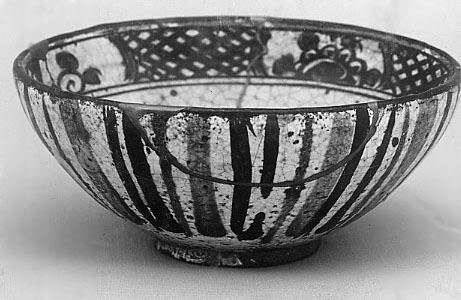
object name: teabowl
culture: japanese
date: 1601-1700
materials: glaze, pottery